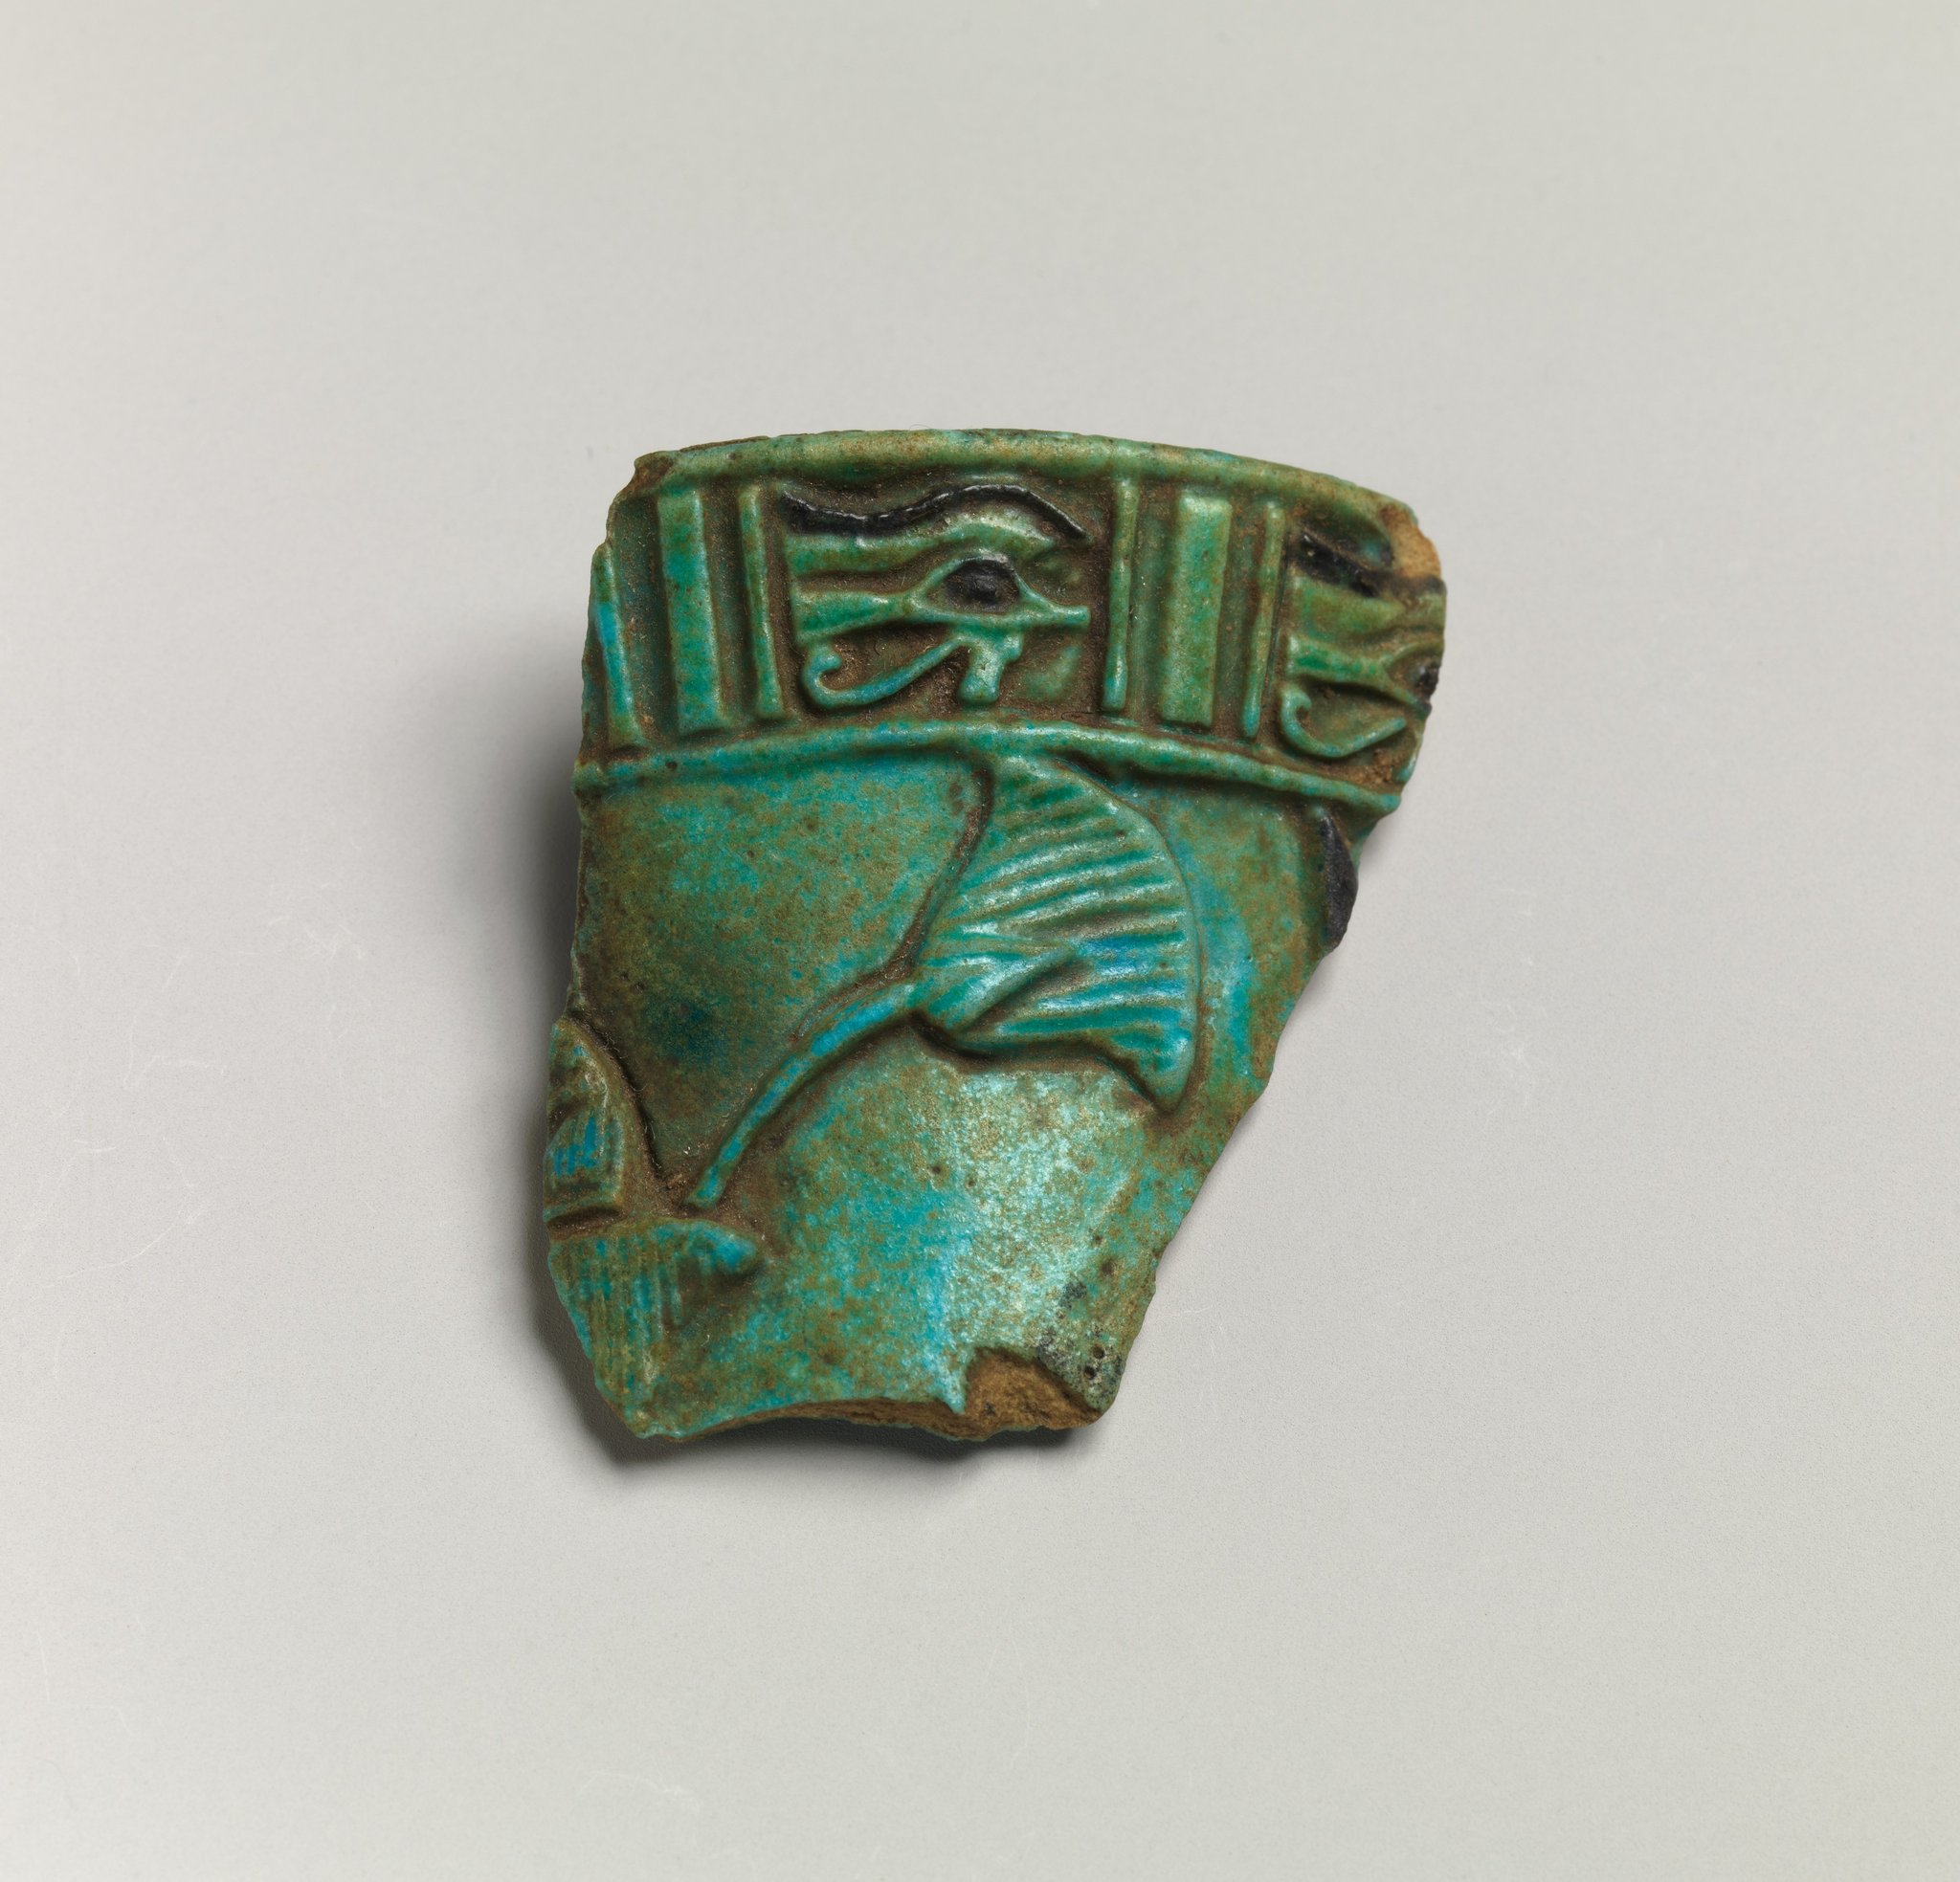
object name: chalice, cup, lotiform, relief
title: See 1986.18.6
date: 1070-712 BCE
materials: faience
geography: egypt